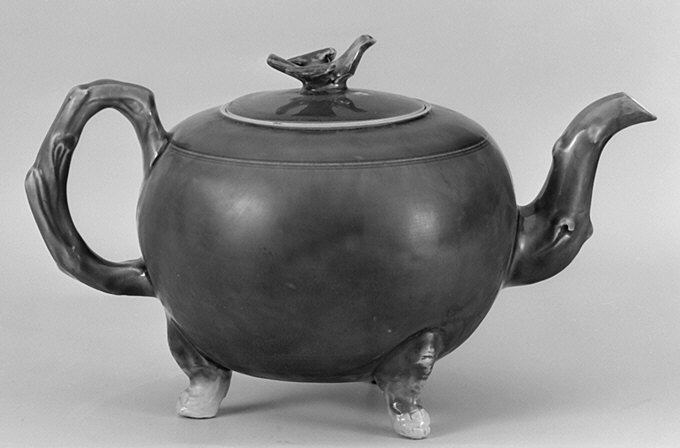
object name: teapot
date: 1755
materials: stoneware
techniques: salt glaze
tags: birds